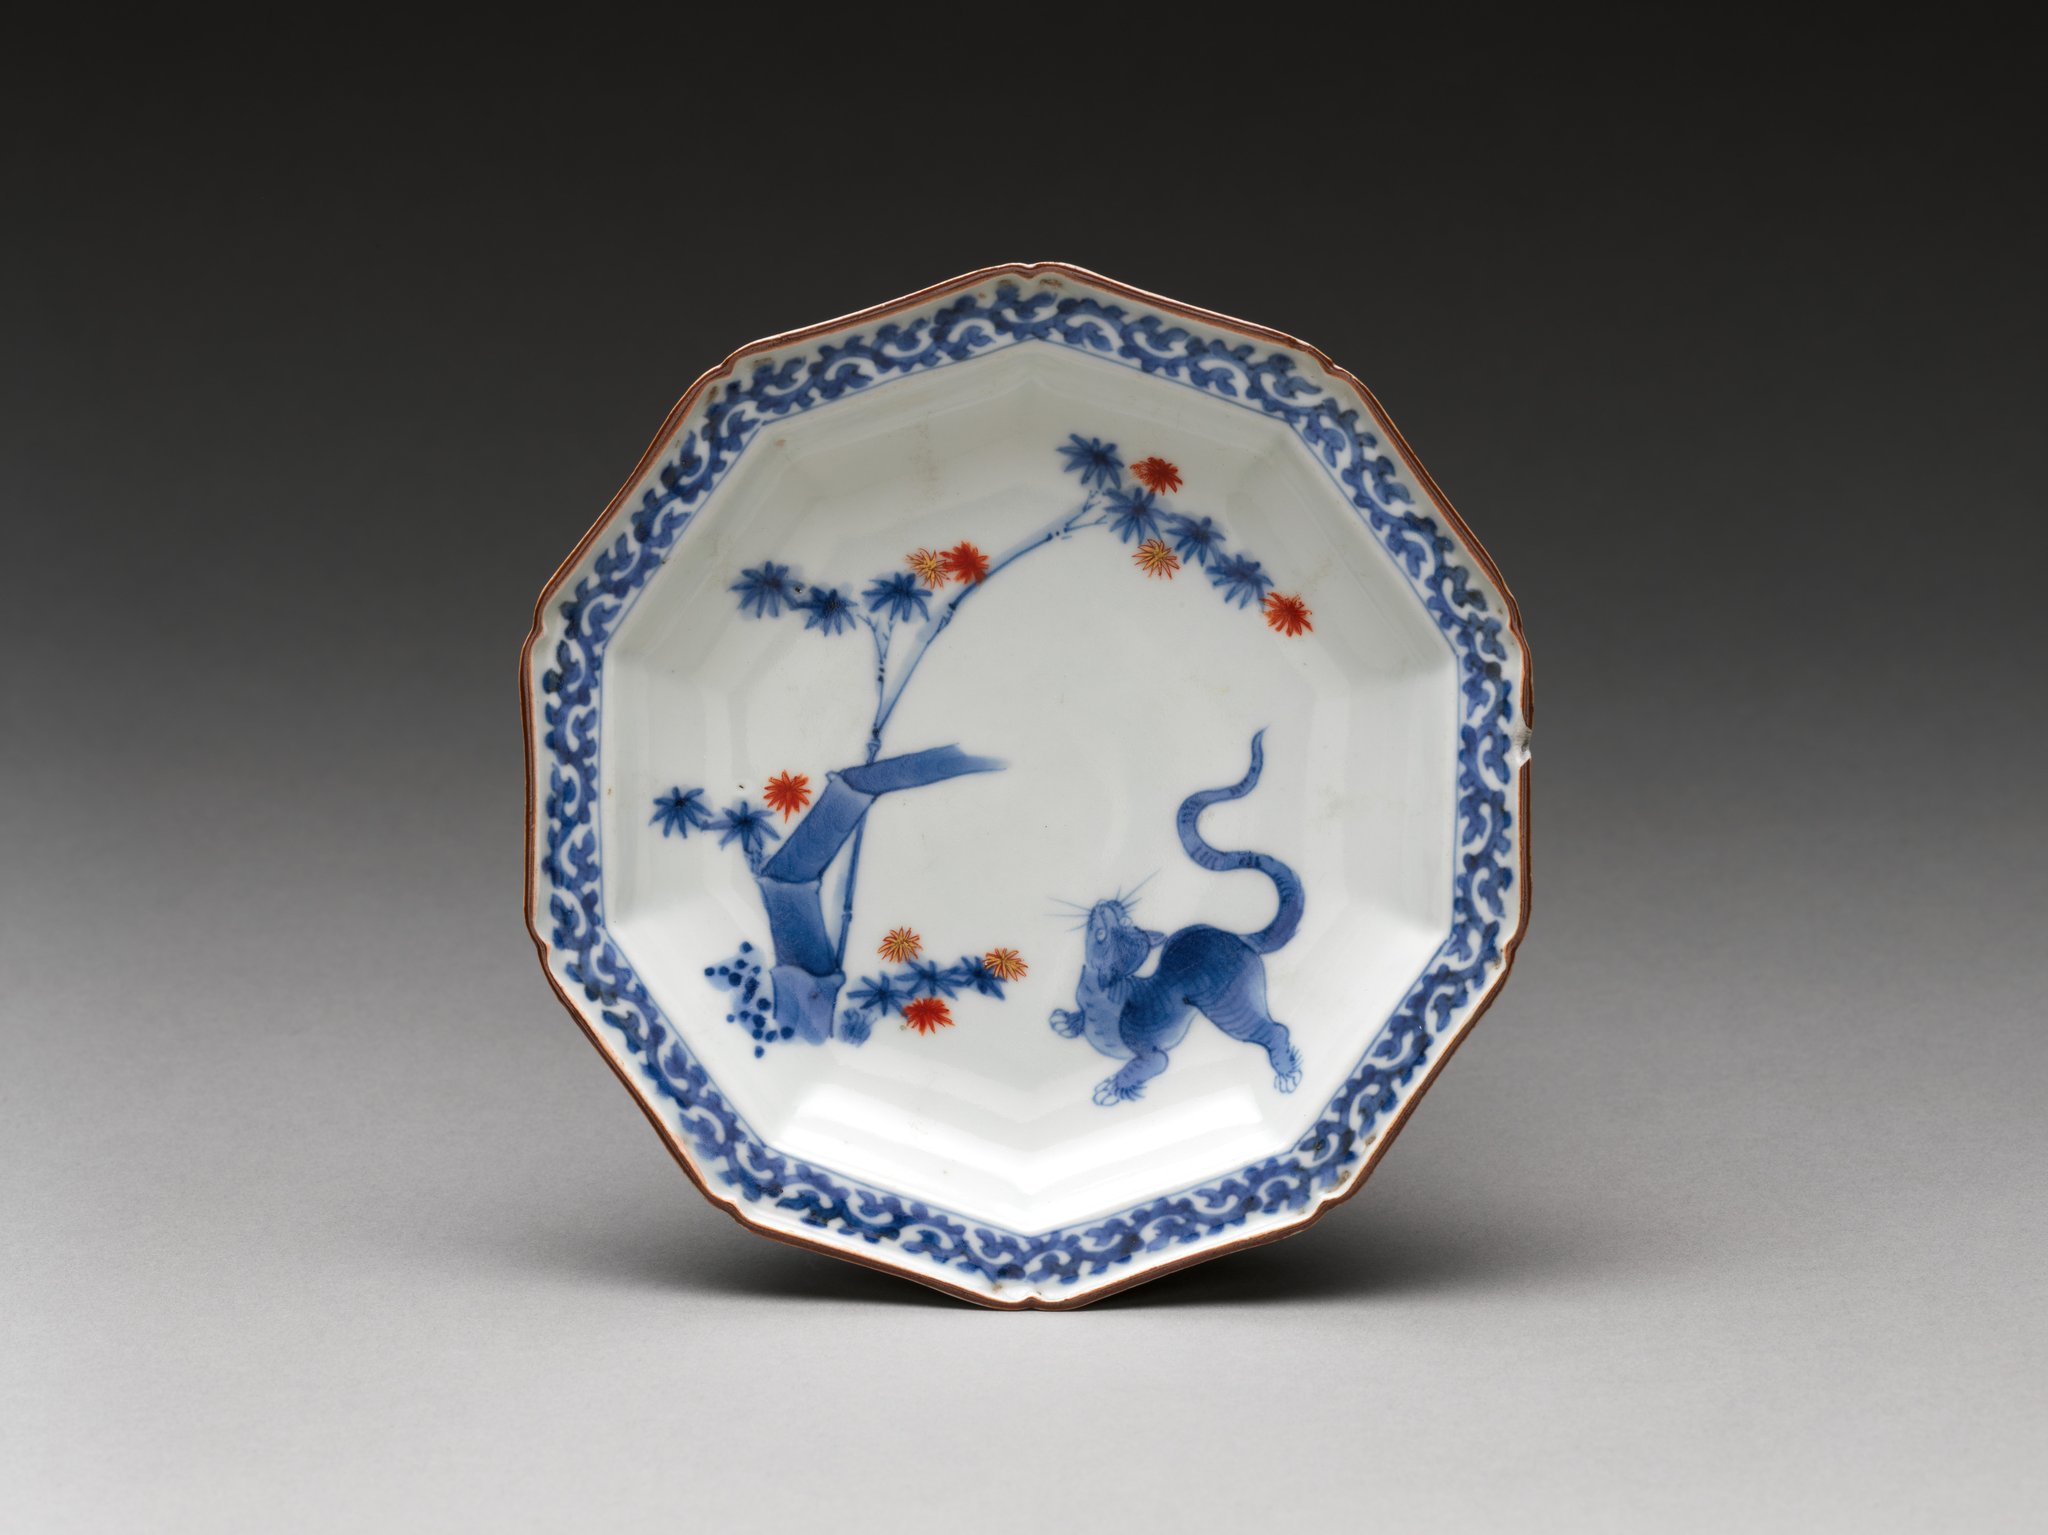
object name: dish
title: Dish with tiger and bamboo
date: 1720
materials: cobalt, glaze, hard paste porcelain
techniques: painting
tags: tigers,bamboo